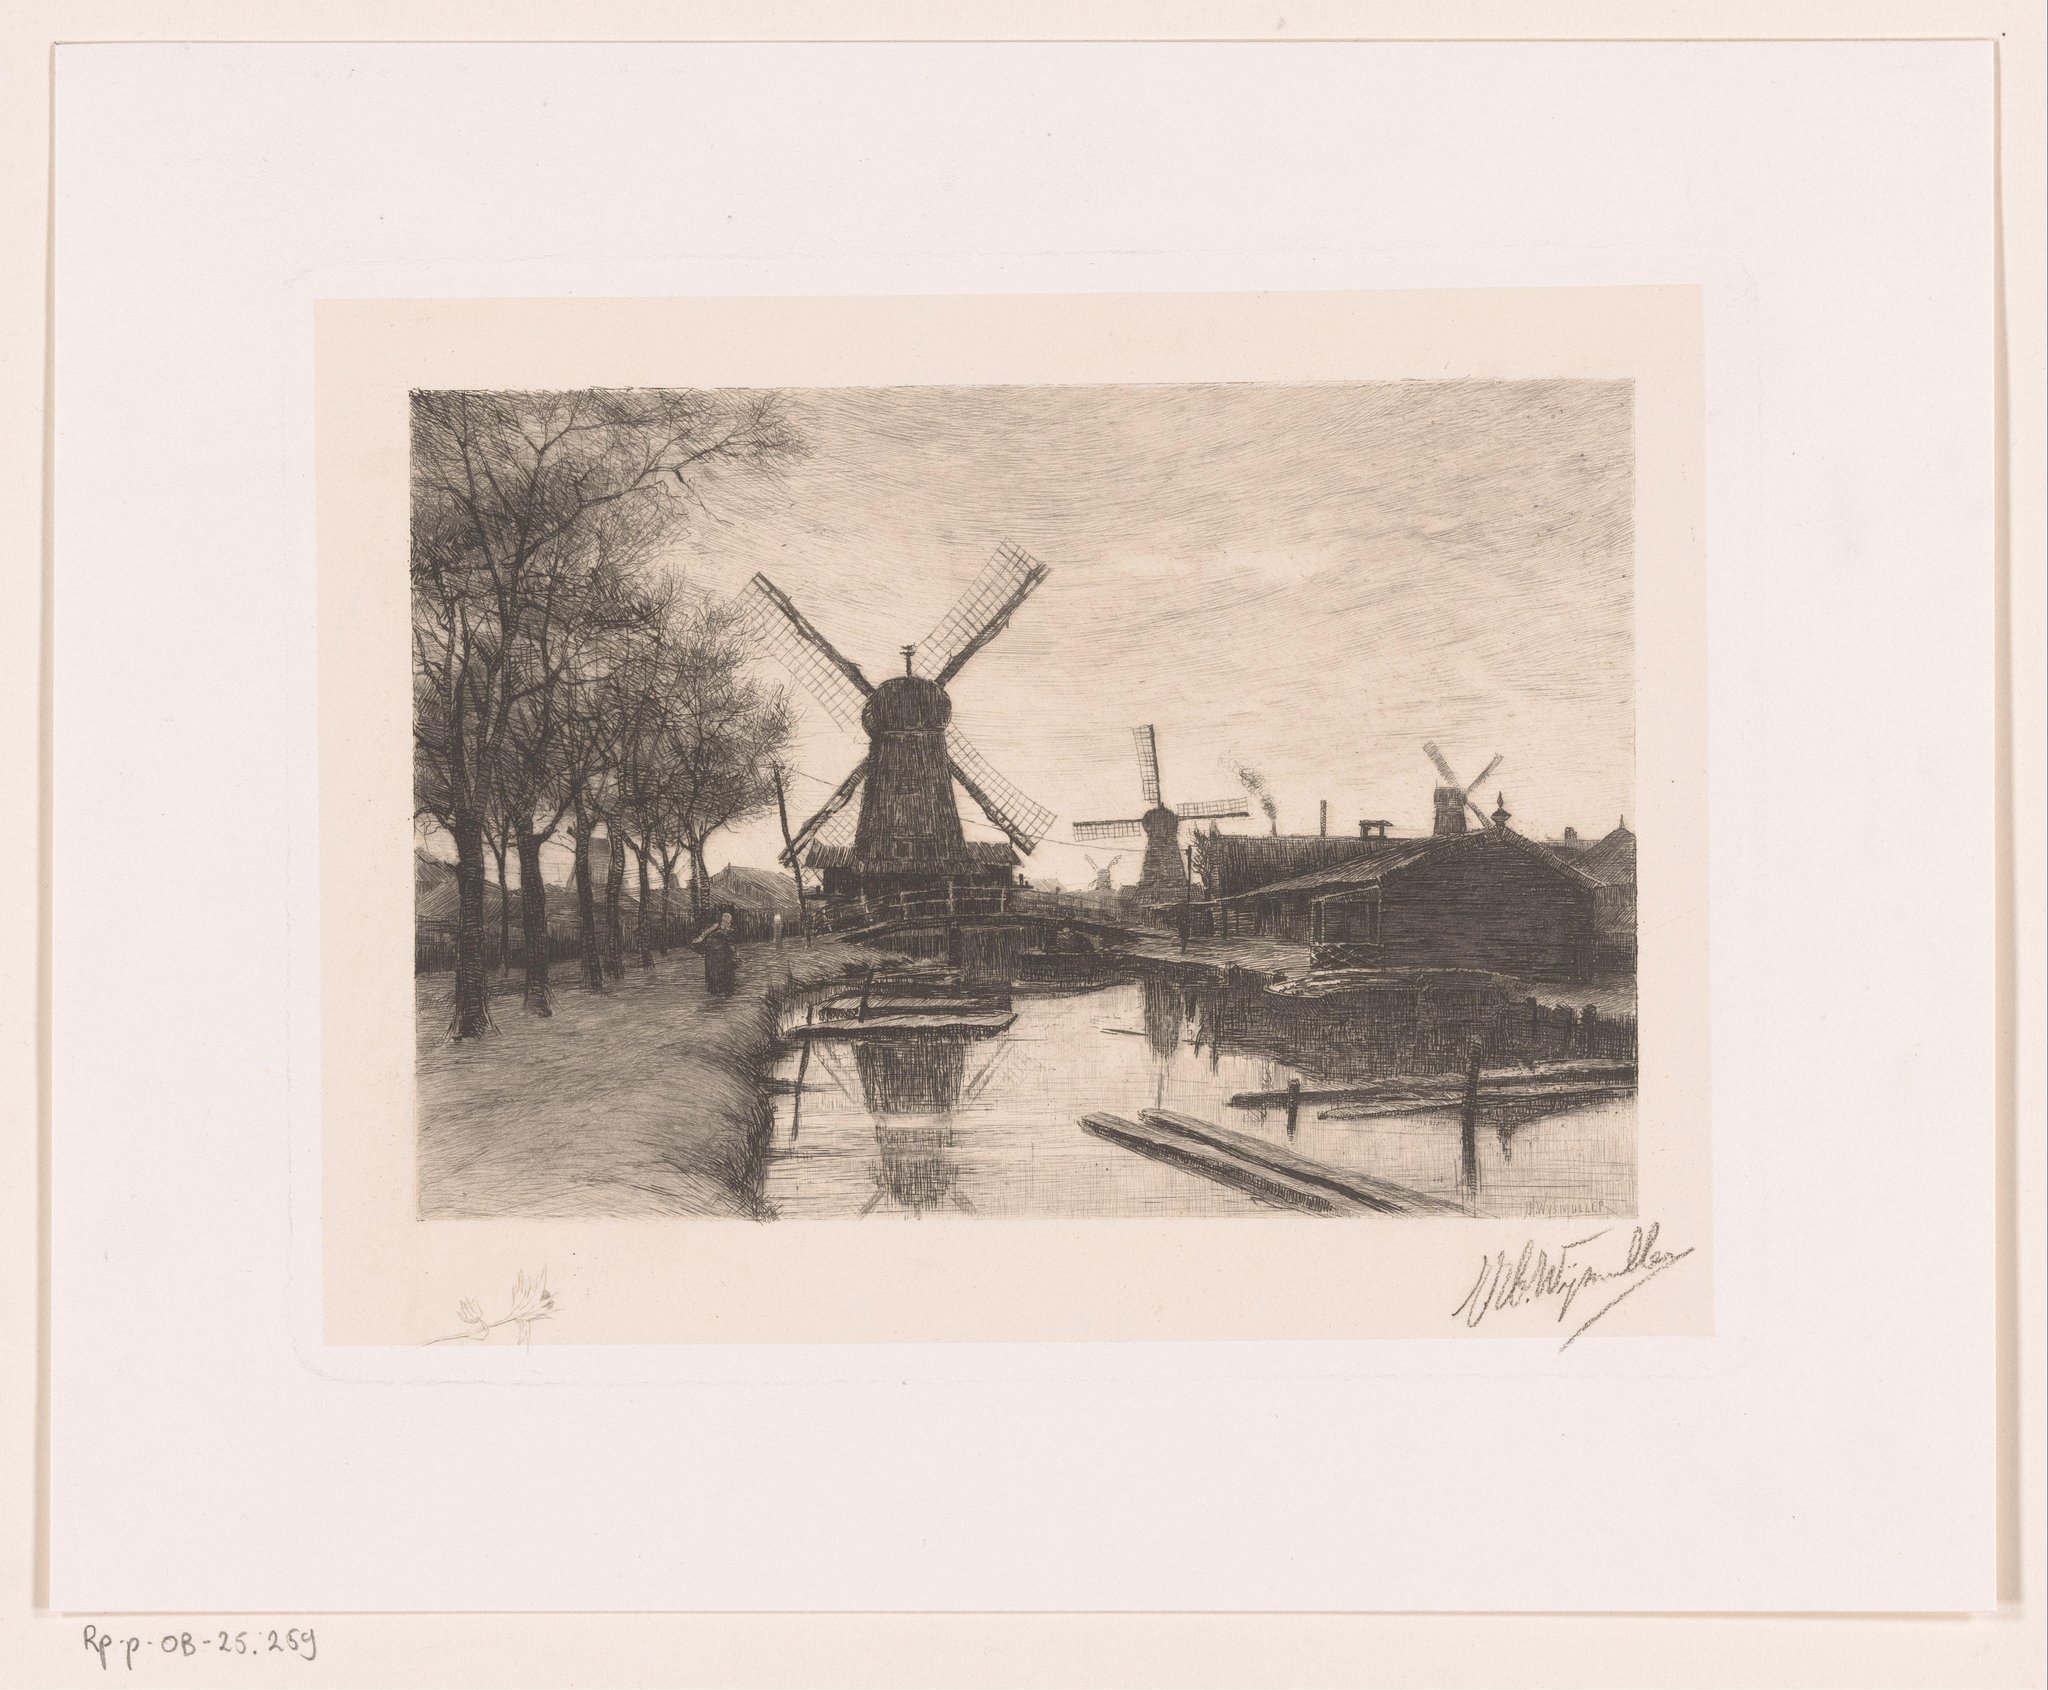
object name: print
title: Gezicht op de Zaagmolensloot bij Amsterdam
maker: jan hillebrand wijsmuller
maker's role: painter, print maker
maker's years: 1855-1925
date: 1865-1925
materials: paper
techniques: drypoint, etching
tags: canal, windmill in landscape, amsterdam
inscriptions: collector's mark: Lugt 2228